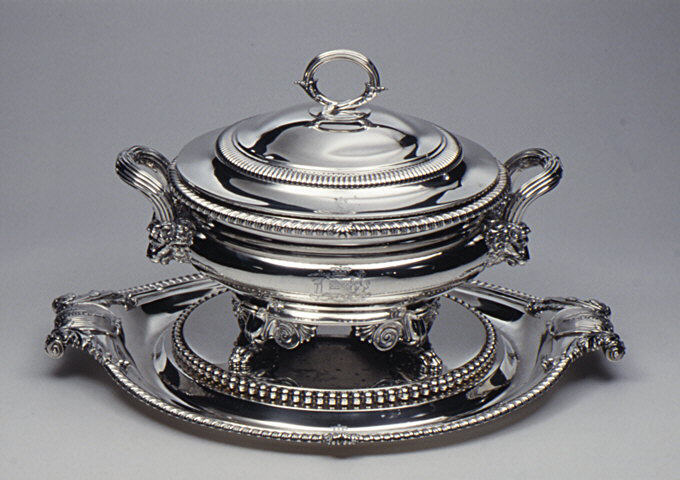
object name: soup tureen with cover and stand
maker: paul storr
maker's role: maker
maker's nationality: british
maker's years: 1771-1844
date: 1806-1808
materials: silver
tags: coat of arms